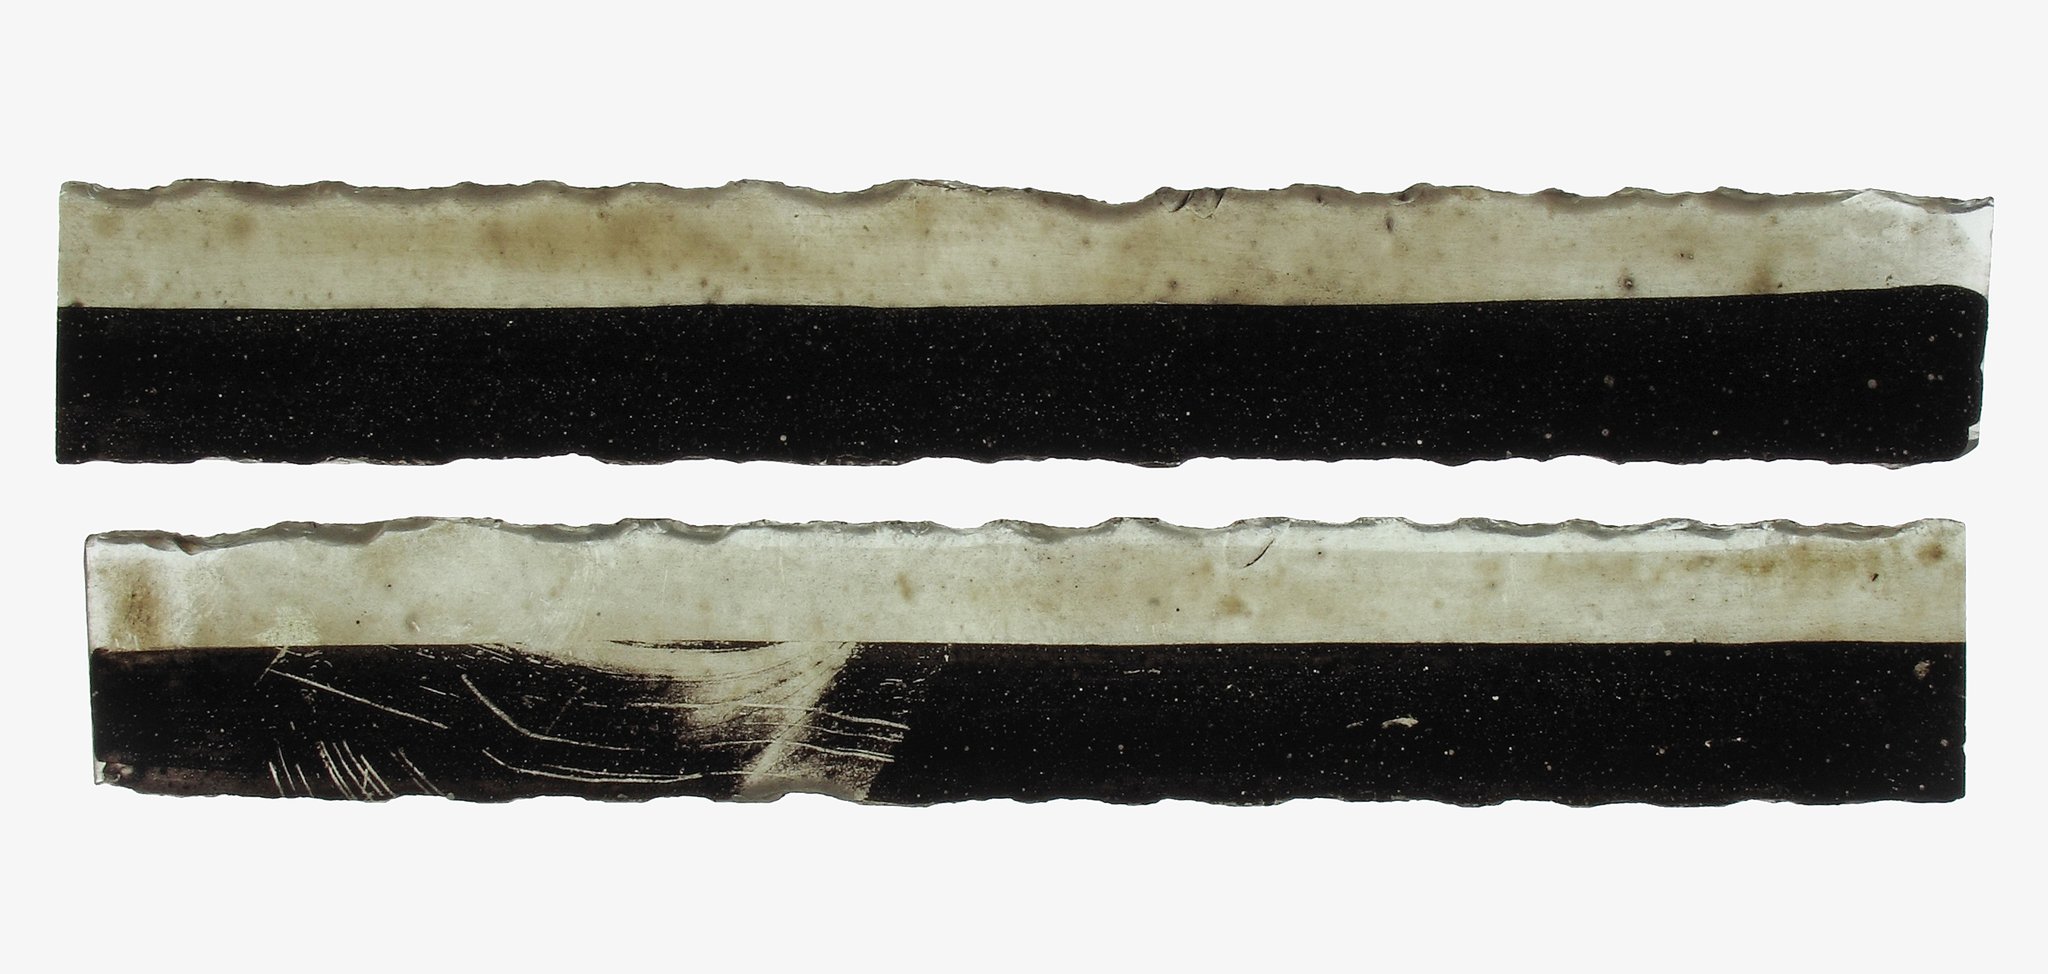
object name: fragment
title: Glass Fragment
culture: european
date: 1301-1500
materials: glass